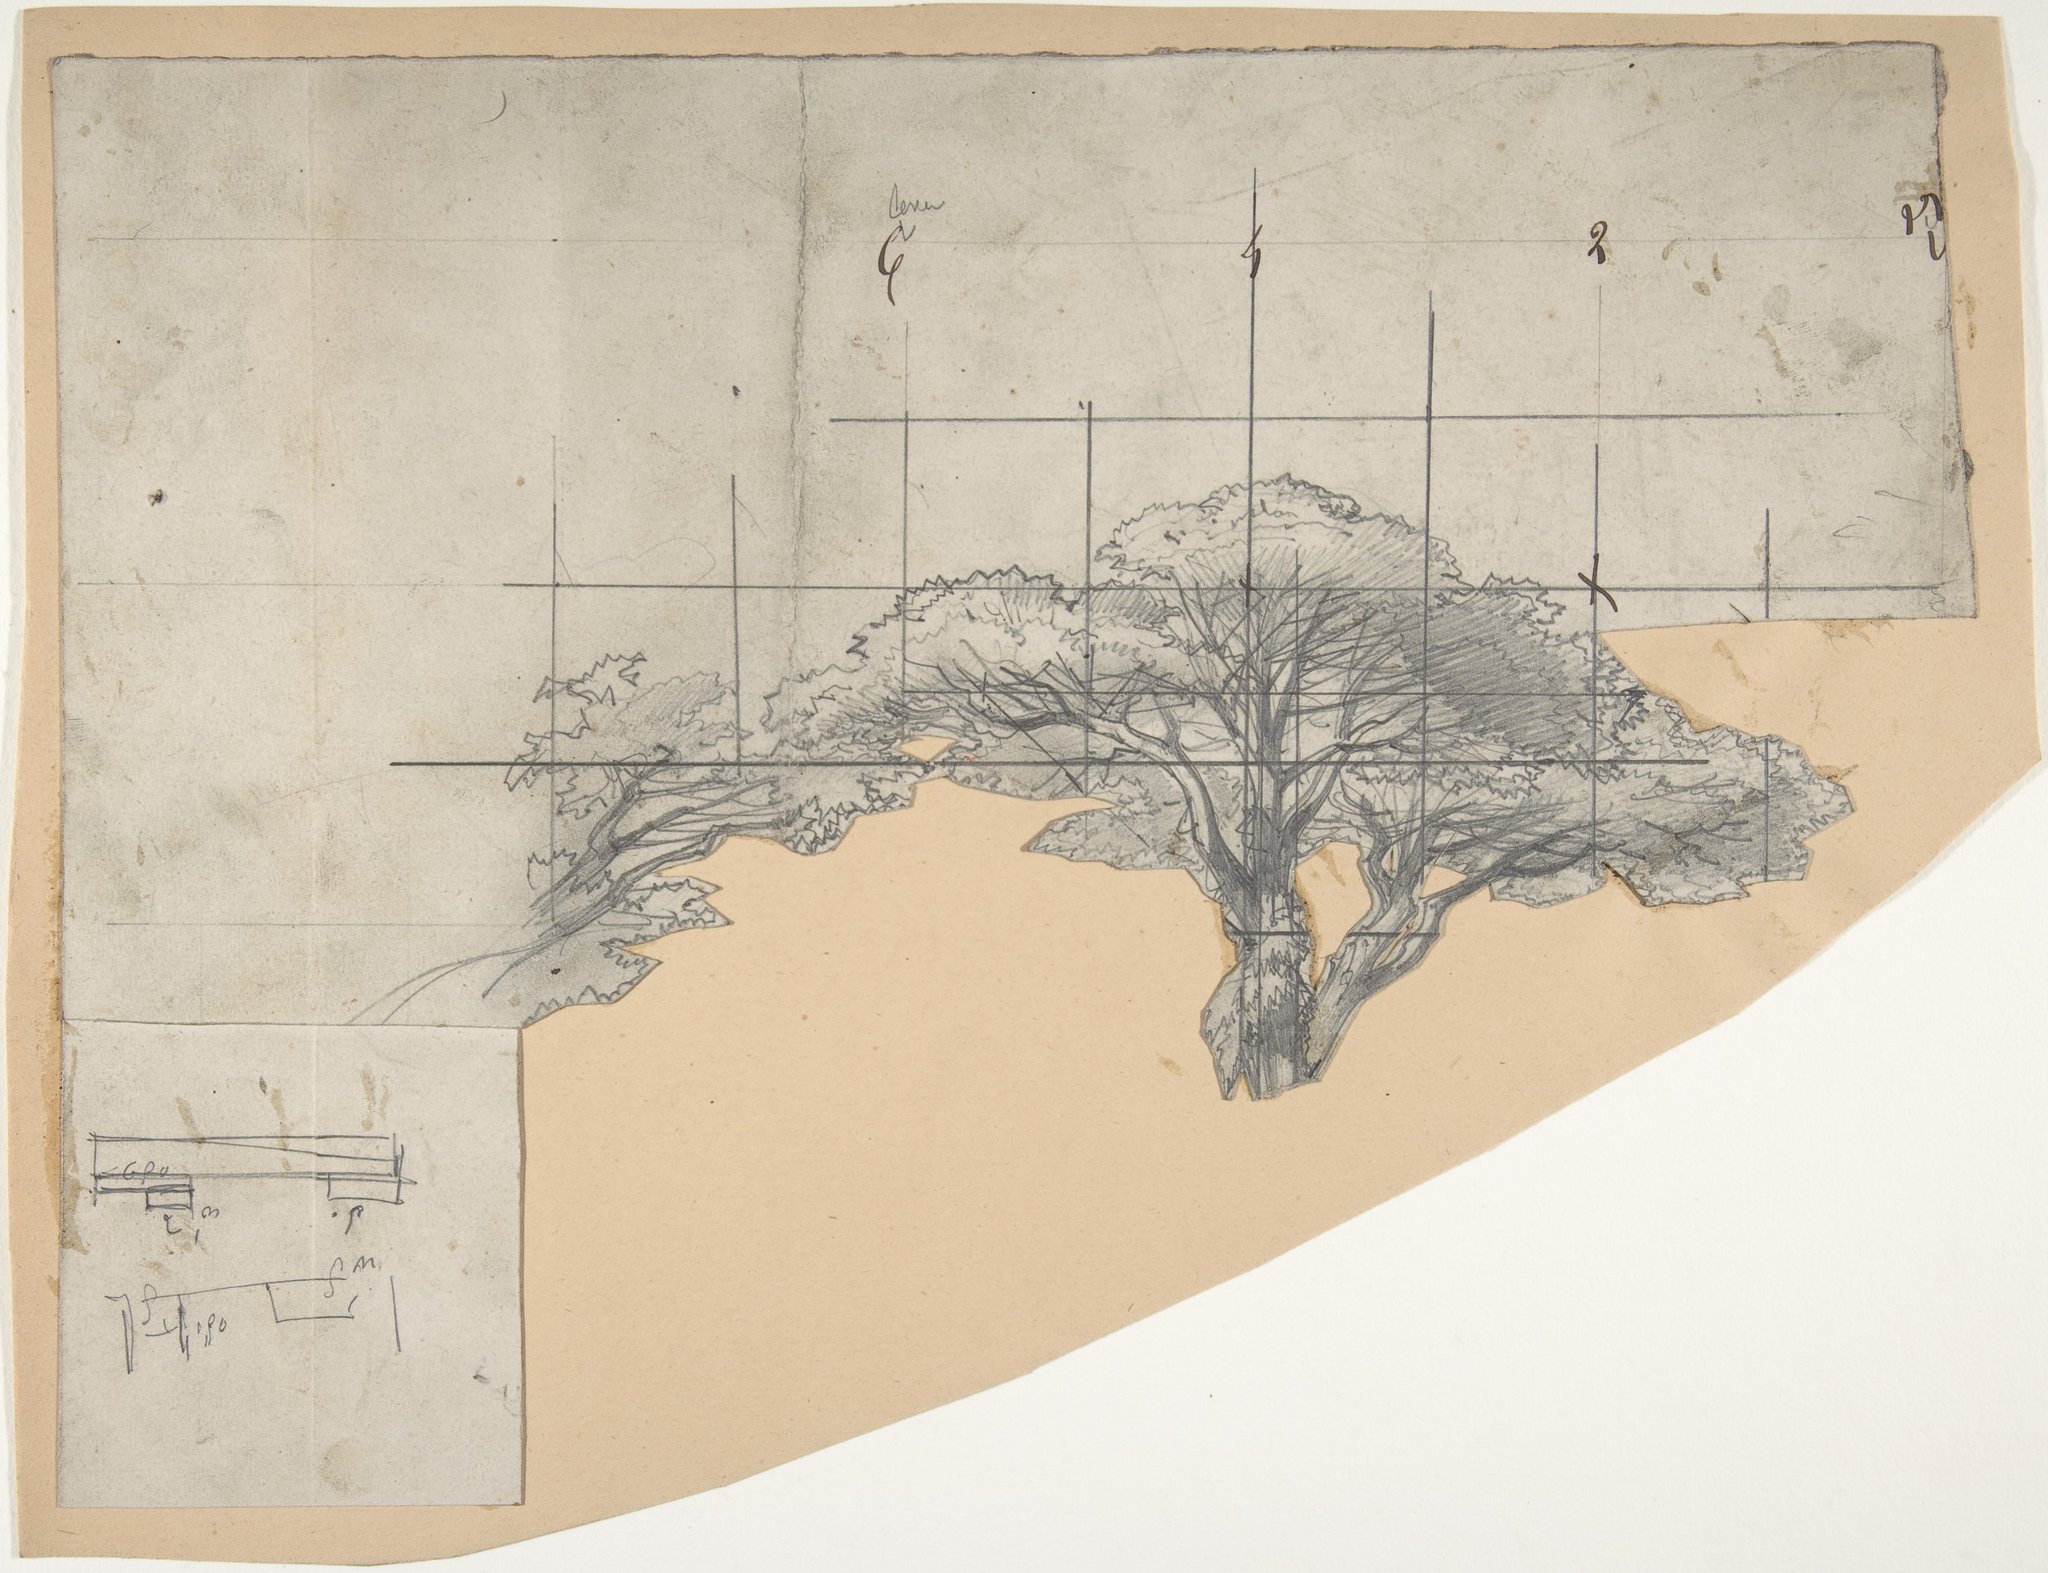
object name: drawing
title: Design for a Stage Set at the Opéra, Paris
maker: eugène cicéri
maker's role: artist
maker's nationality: french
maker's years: 1813-1890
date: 1840-1890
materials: graphite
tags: trees,stage design